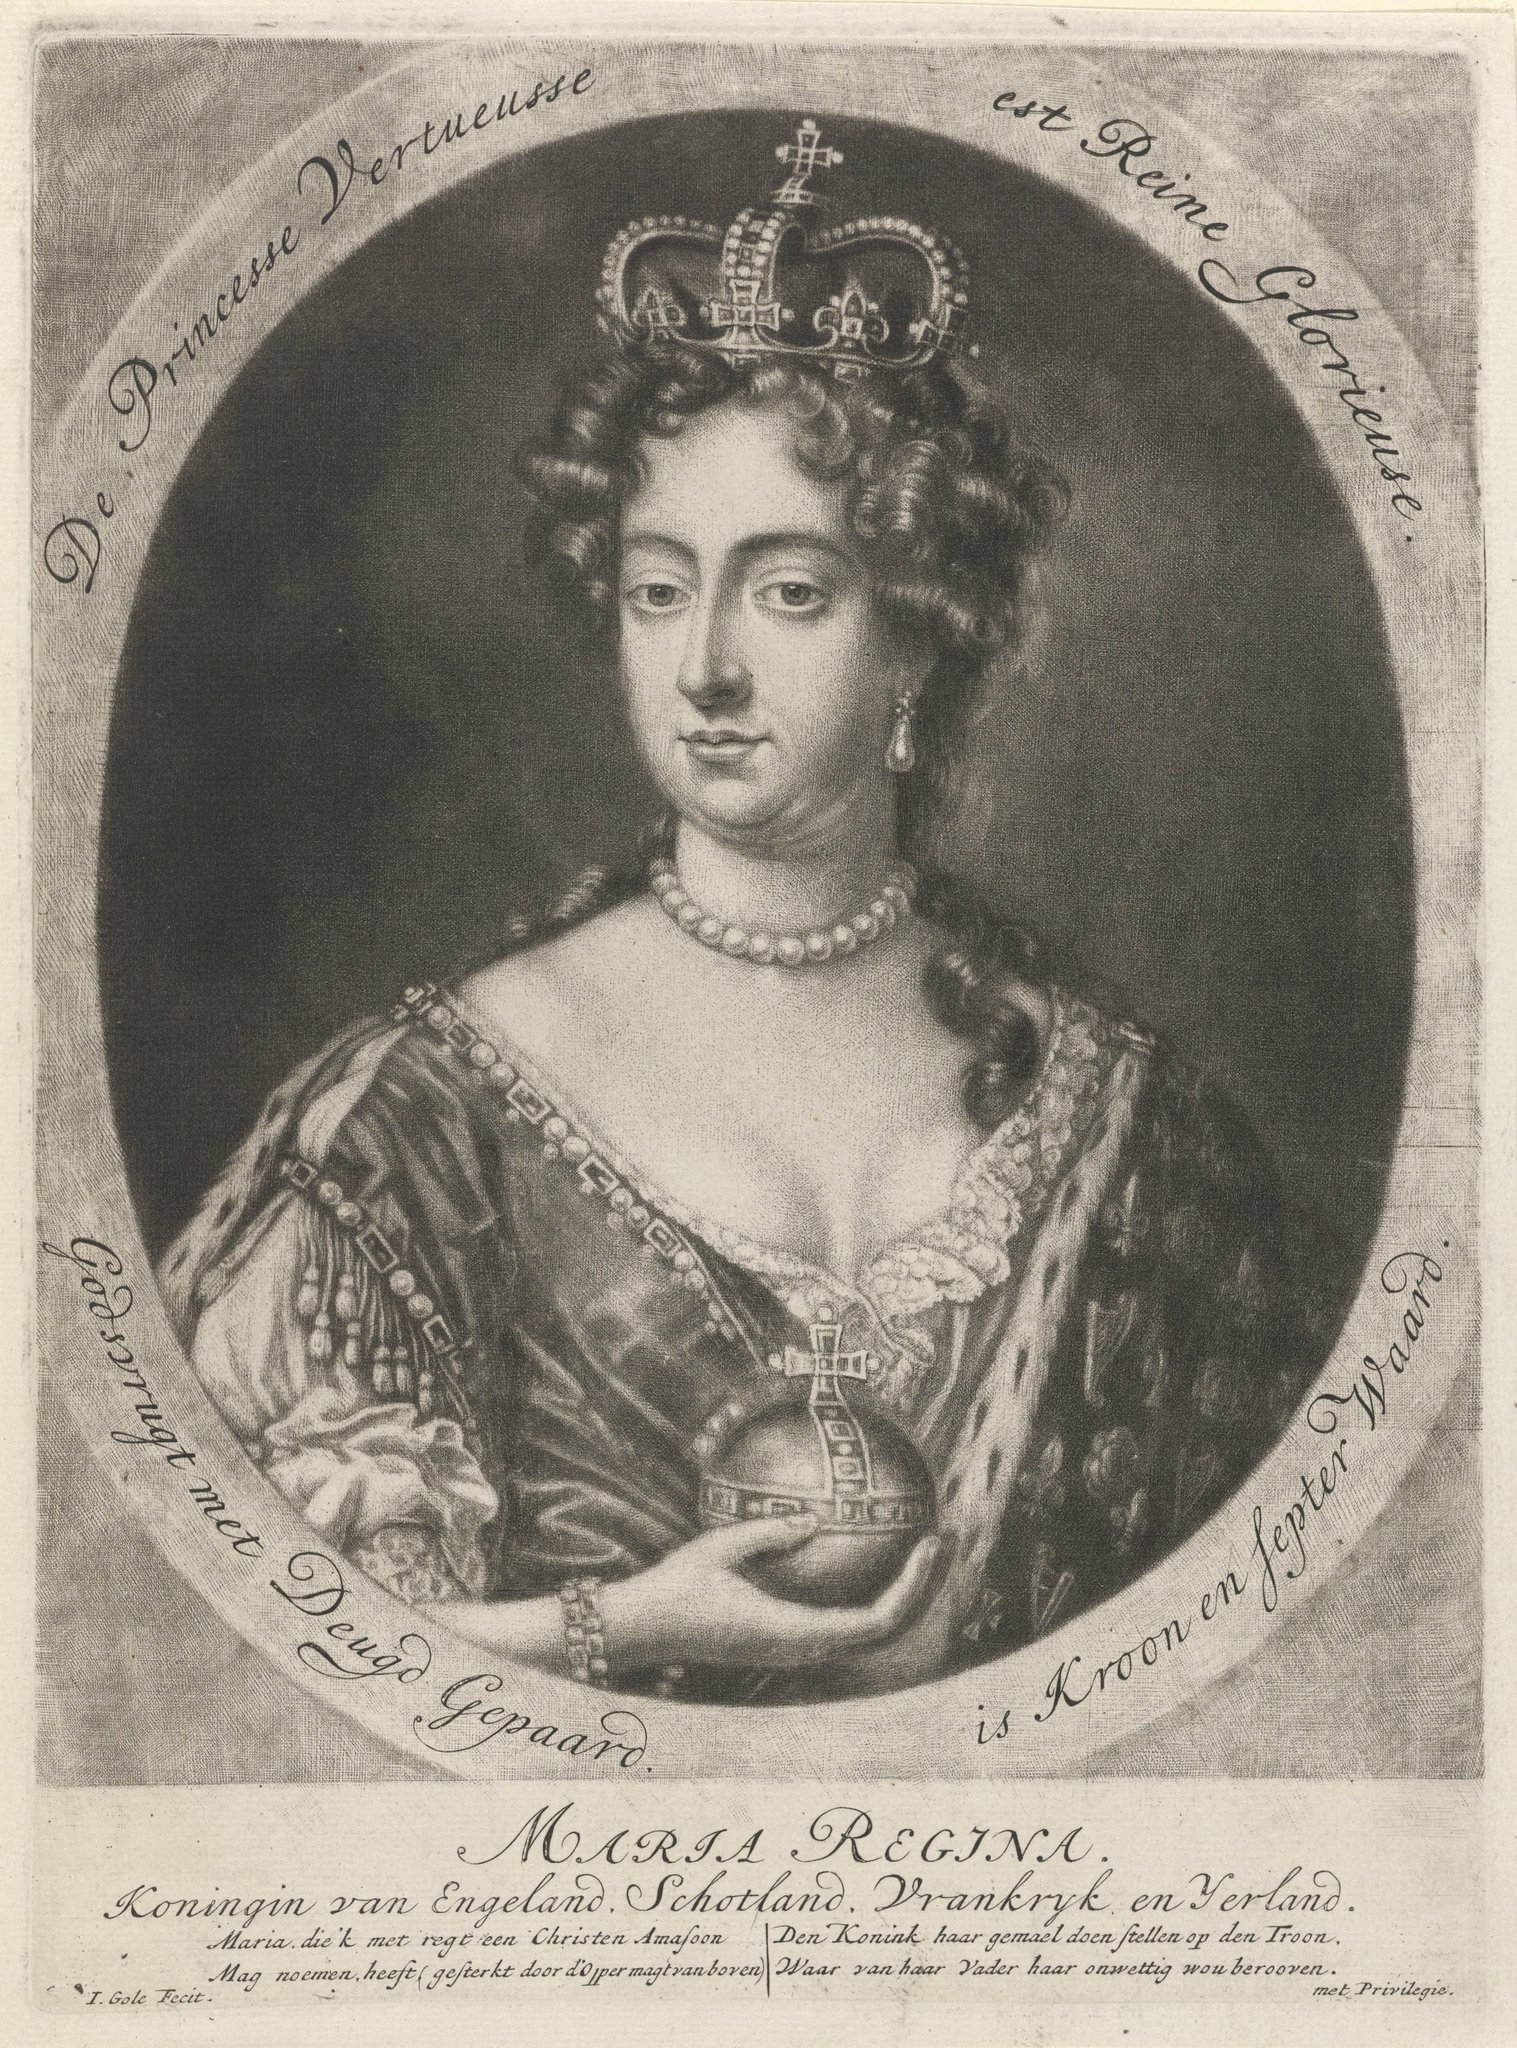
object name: print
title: Portret van Maria II Stuart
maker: jacob gole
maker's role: print maker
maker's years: 1660-1724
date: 1688-1724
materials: paper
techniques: mezzotint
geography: amsterdam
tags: london, maria ii stuart (koningin van engeland, schotland en ierland)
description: Portret van Maria II met een kroon in een ovaal met randschrift. In haar rechterhand de rijksappel. In de ondermarge haar naam, haar titels en twee kolommen met elk twee regels Nederlandse tekst.